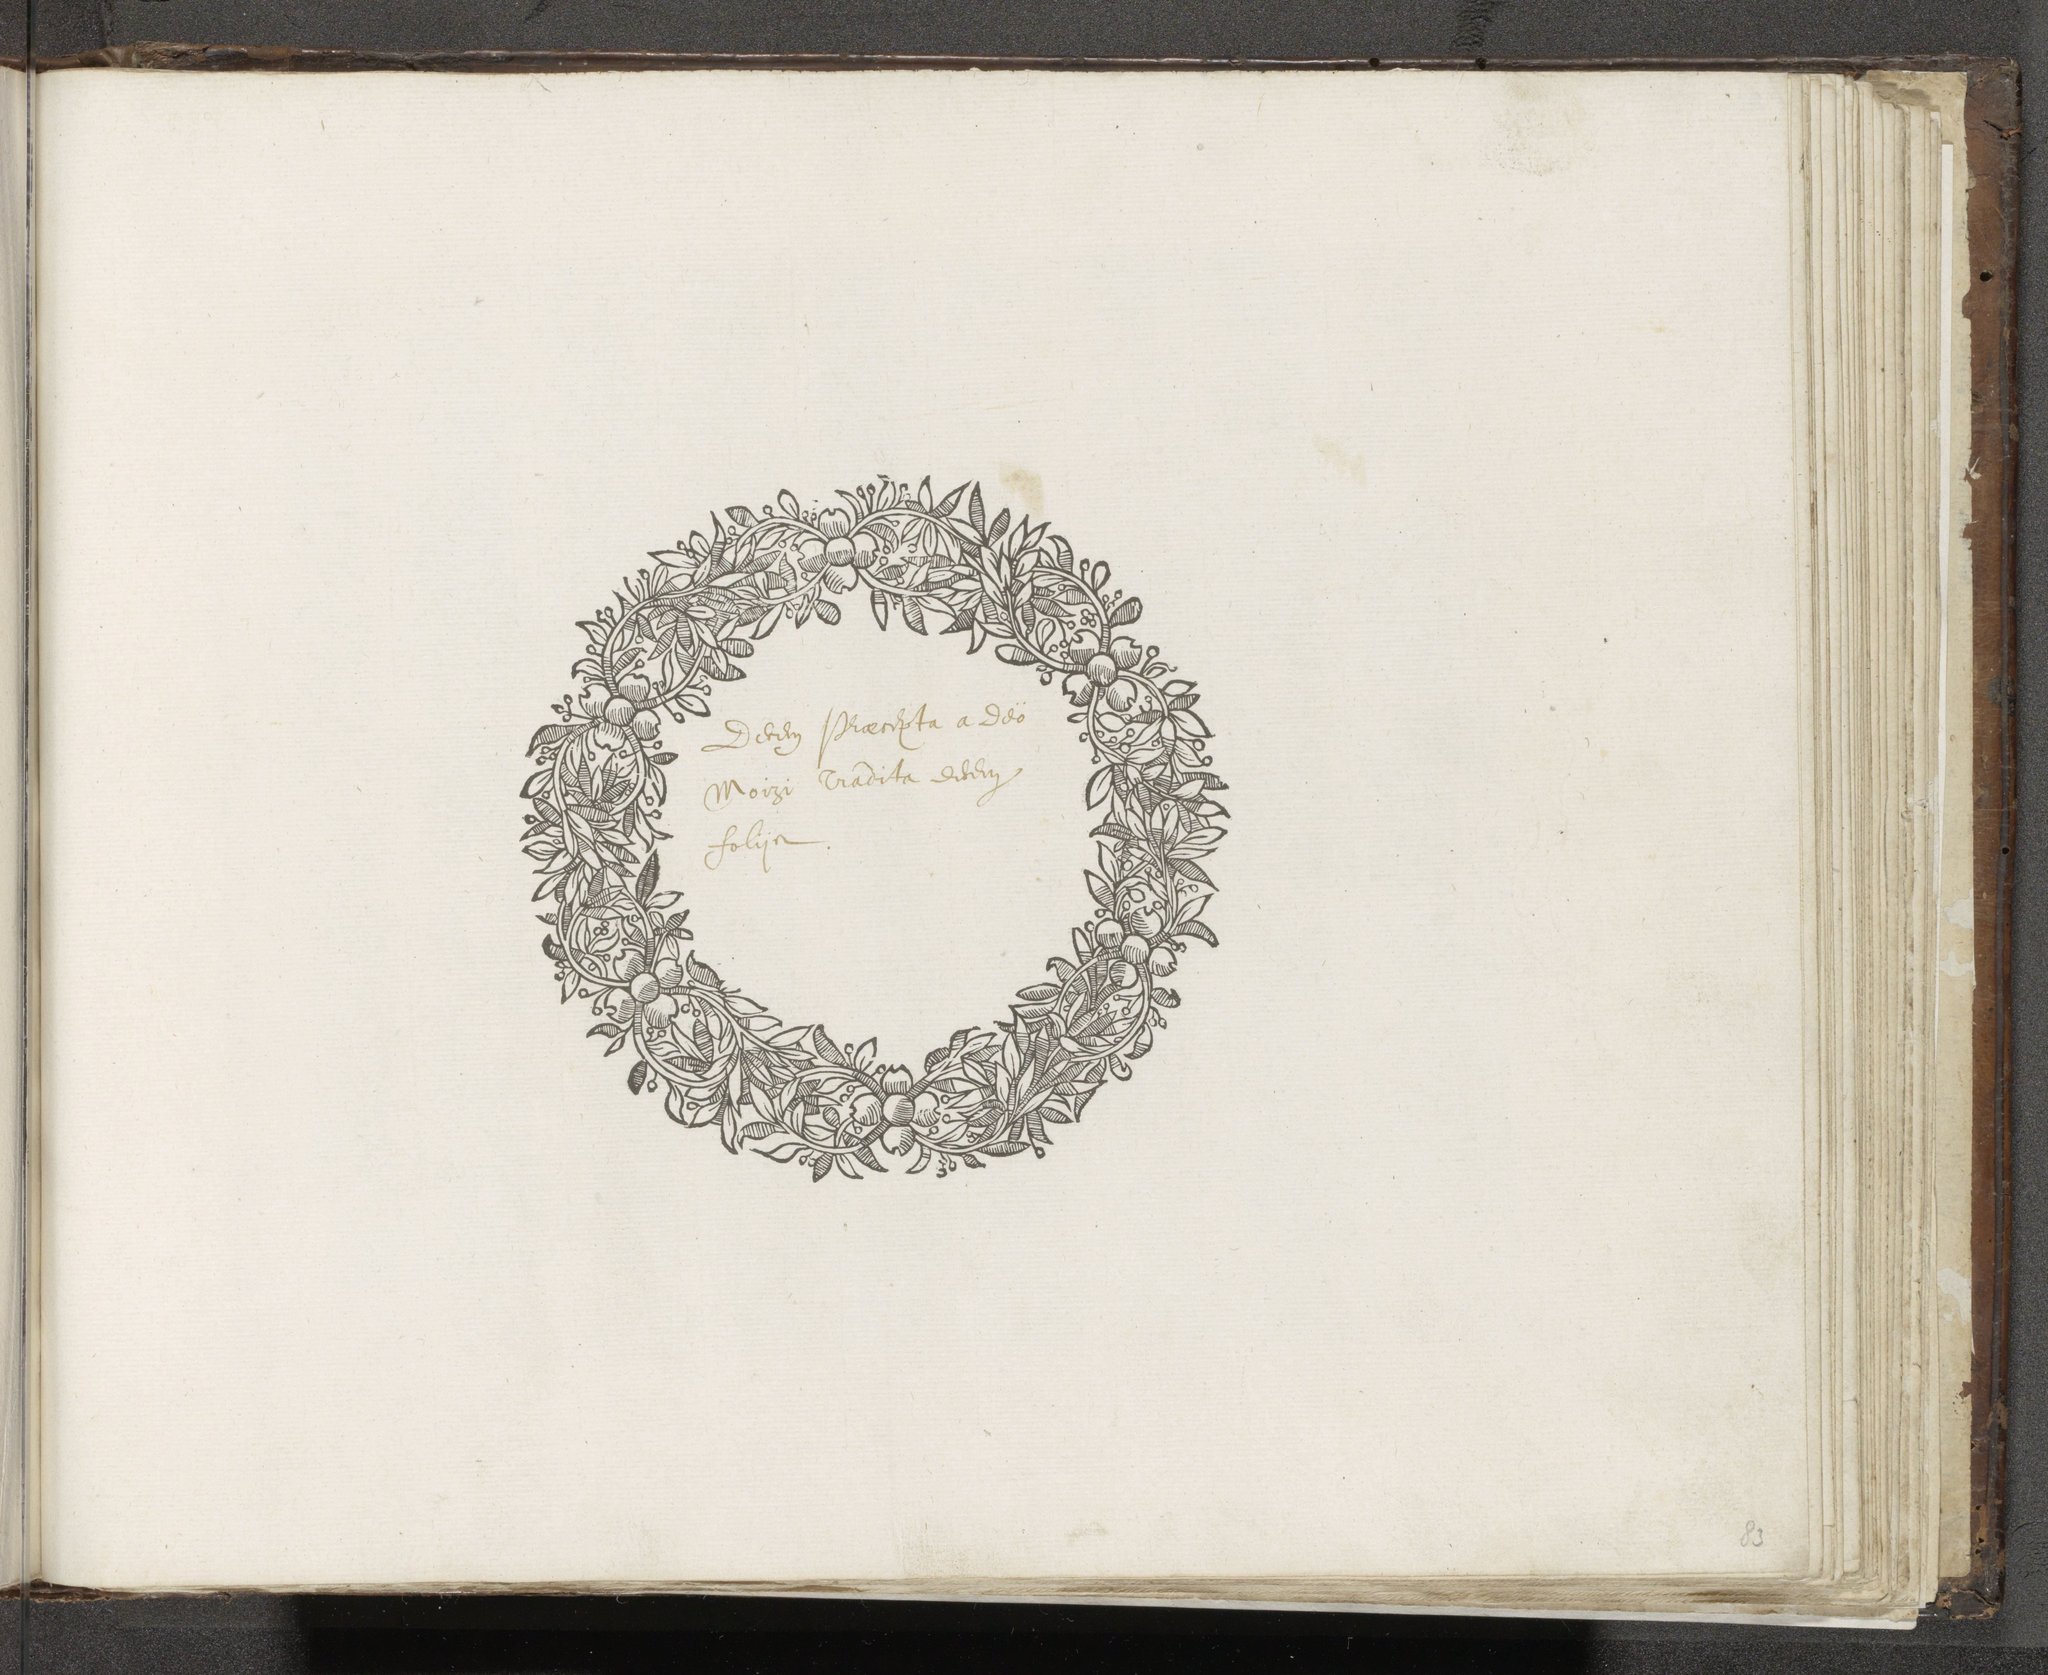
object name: print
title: Thesaurus sacrarum historiaru[m] veteris testame[n]ti, elega[n]tissimis imaginibus expressu[m] excelle[n]tissimoru[m] in hac arte viroru[m] opera: nu[n]c primu[m] in luce[m] editus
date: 1579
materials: paper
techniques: woodcut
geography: antwerp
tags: garland, wreath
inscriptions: inscription: ‘Ditily Poenesta a Idö Moizi Tradita [...] folijn’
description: Ornamentele bloemenkrans met in het midden een handgeschreven titel. Prent maakt deel uit van een album.